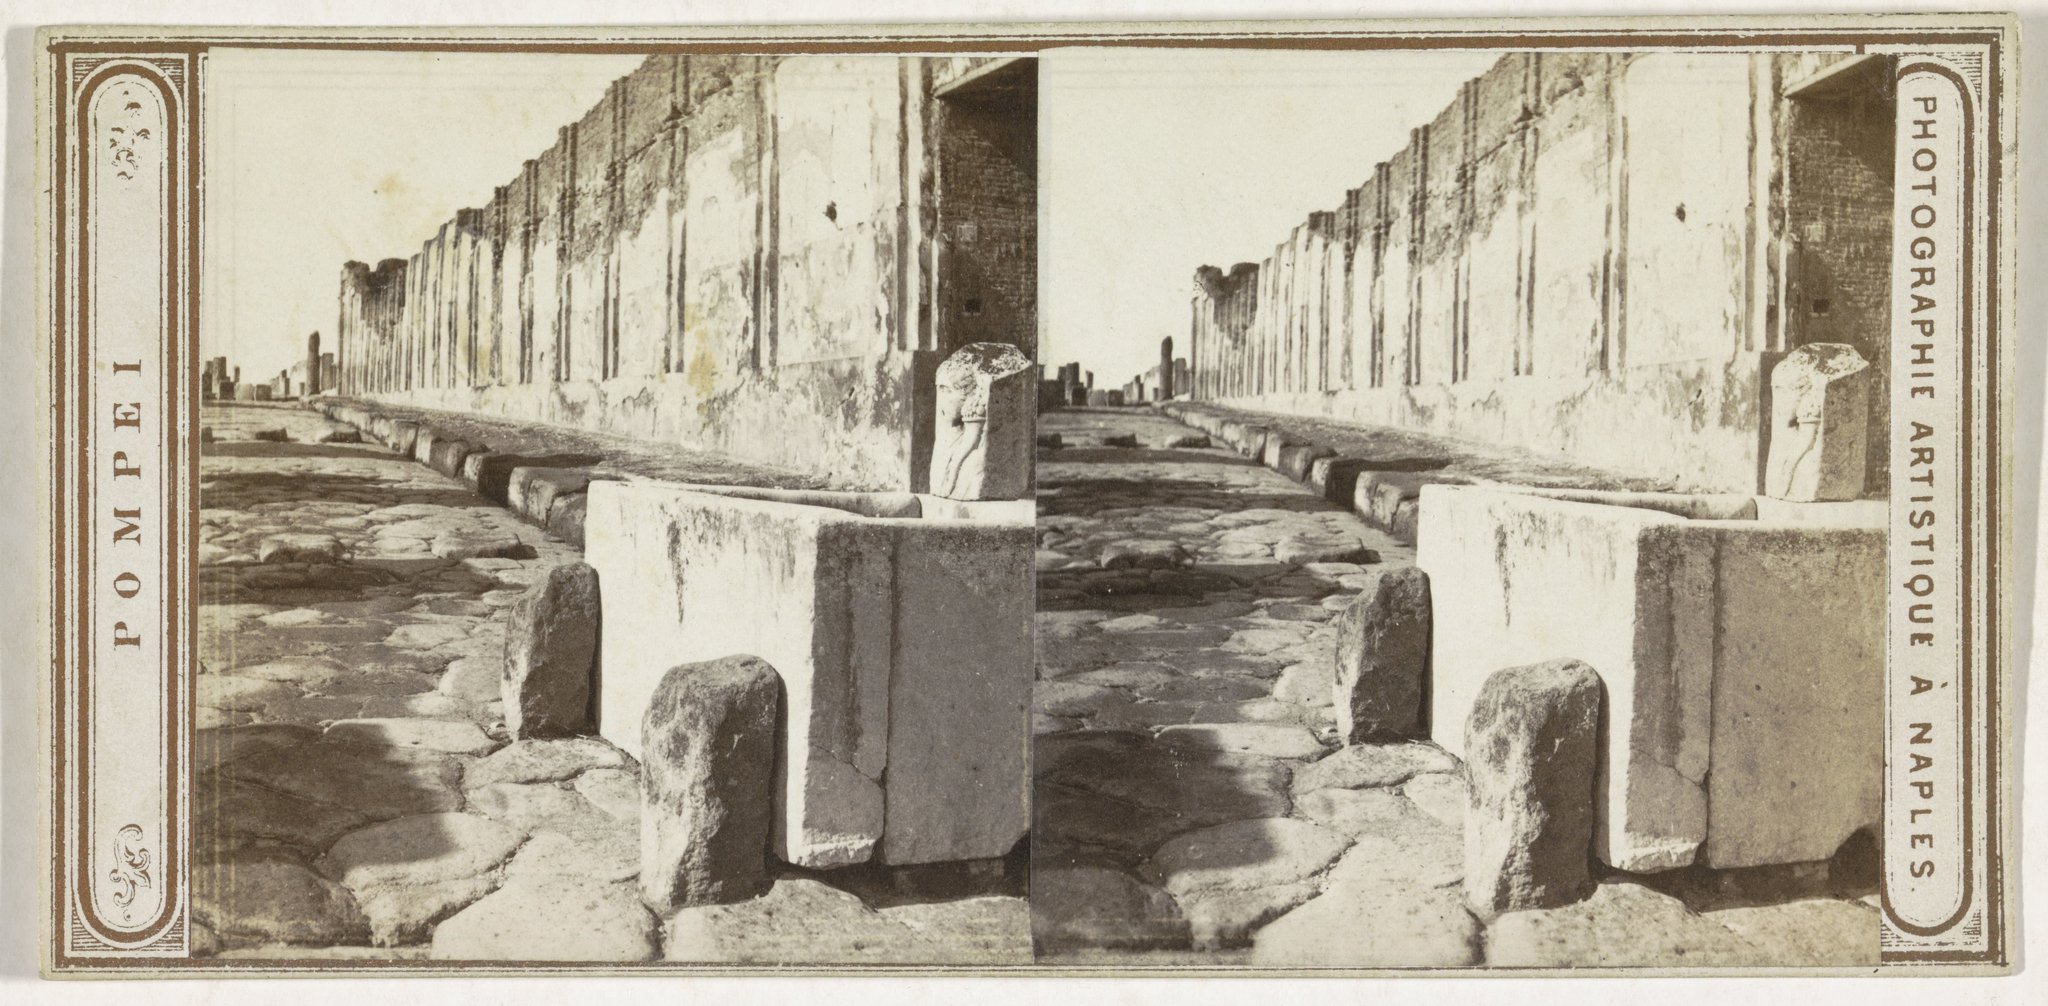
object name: stereograph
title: Pompei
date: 1865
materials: cardboard, paper, photographic support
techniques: albumen print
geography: naples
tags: pompeii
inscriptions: annotation: ‘Photographie à l'albumine circa 1865.’, annotation: ‘Pompei fontaine abondance’, inscription: ‘15 €’